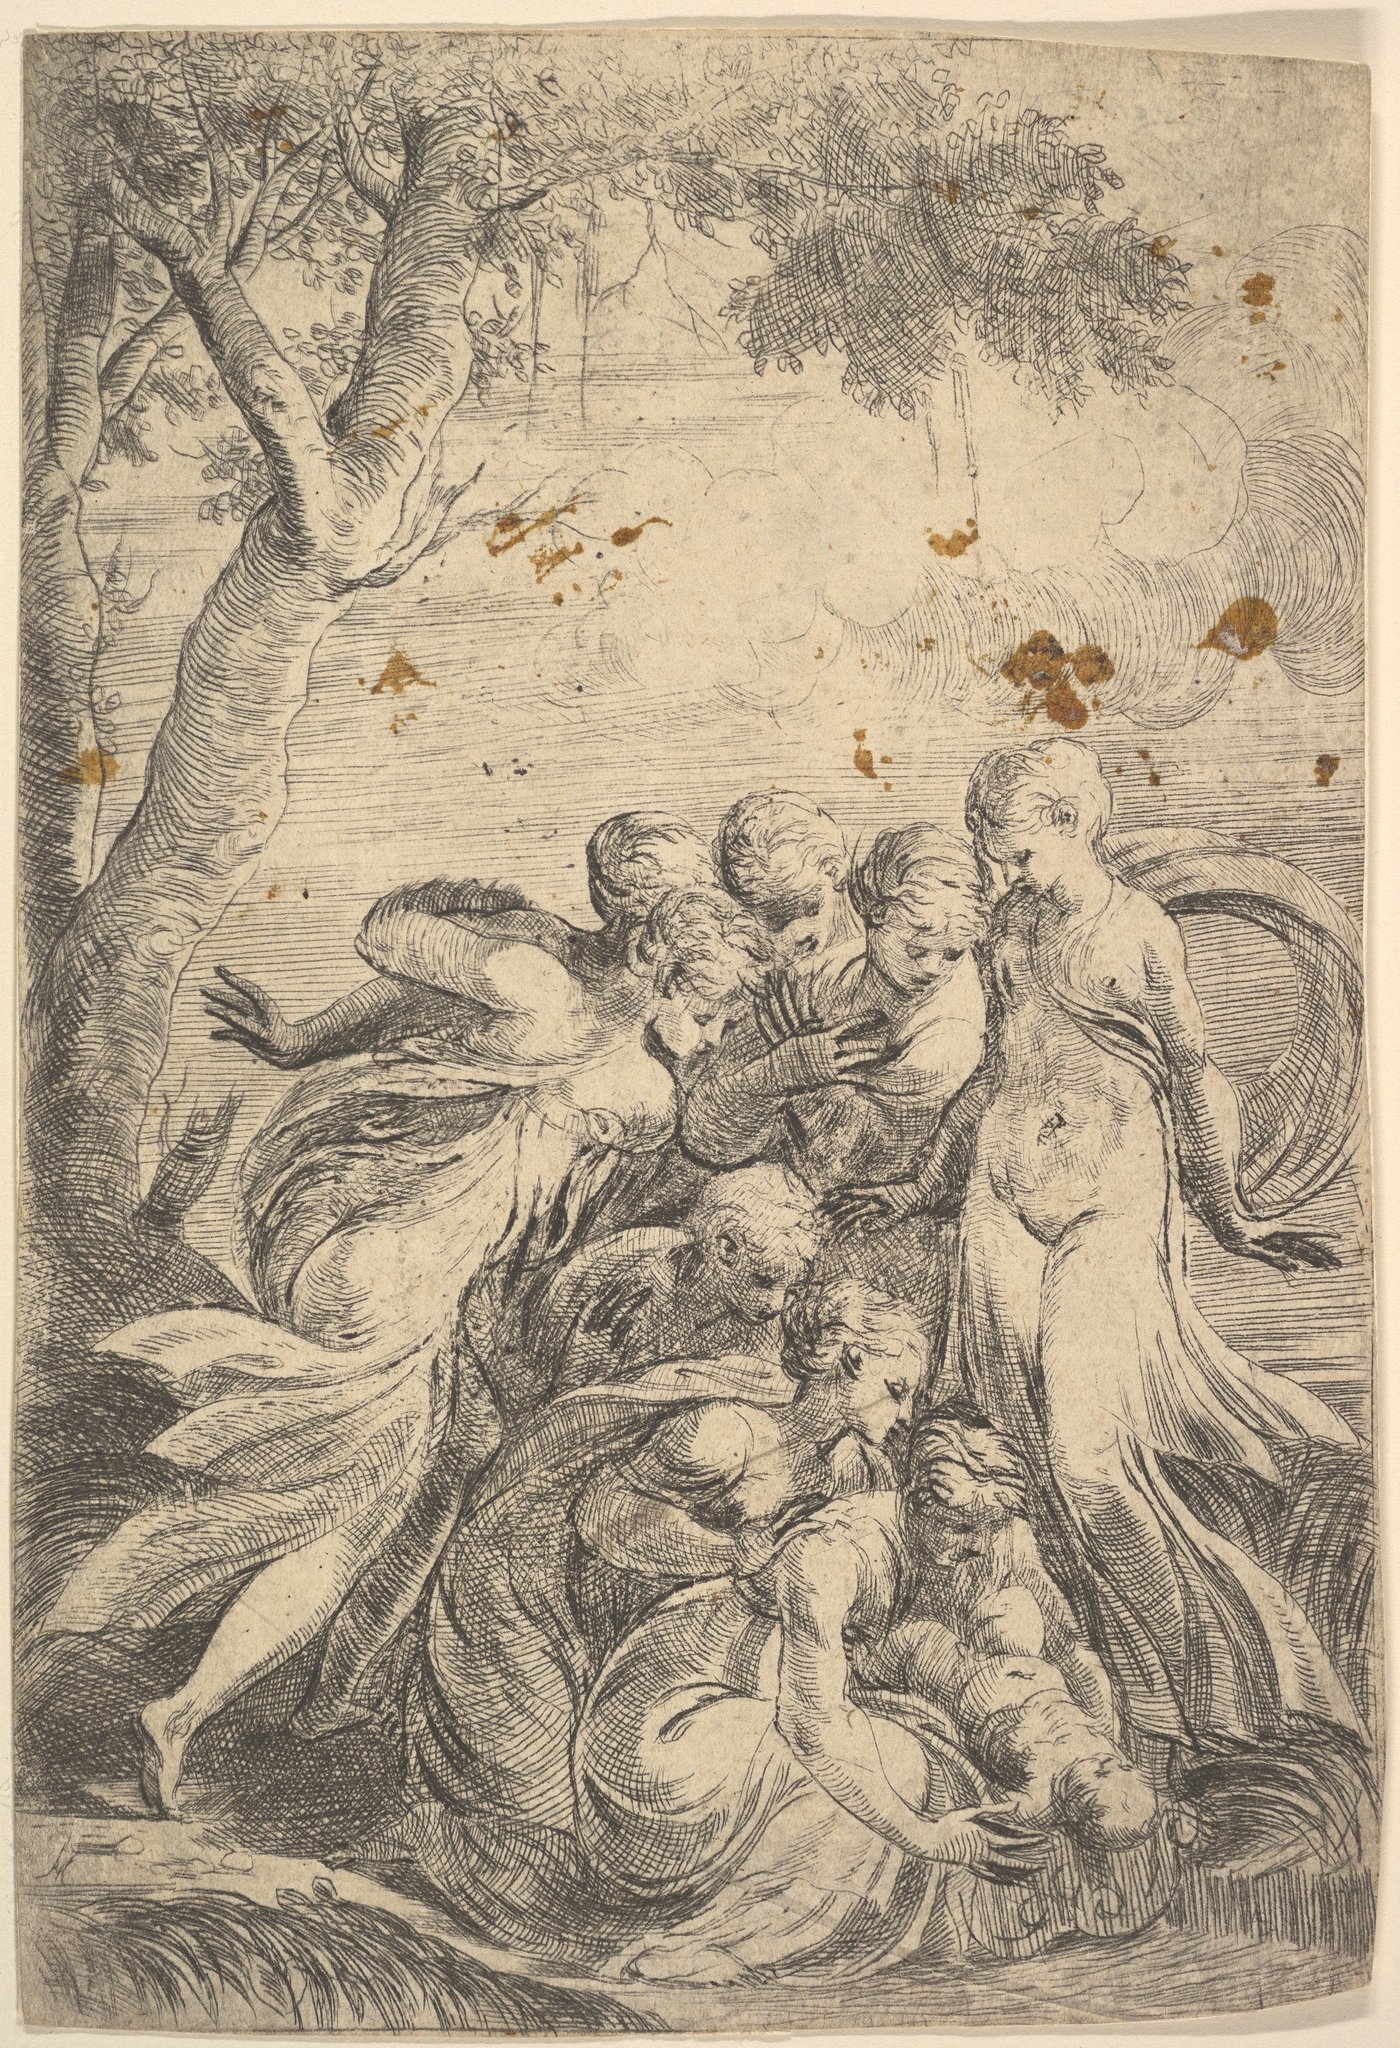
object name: print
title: The infant Moses rescued from the Nile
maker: andrea schiavone (andrea meldola)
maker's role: artist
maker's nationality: italian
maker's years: 1510-1563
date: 1540-1545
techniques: etching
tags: princesses,girls,moses